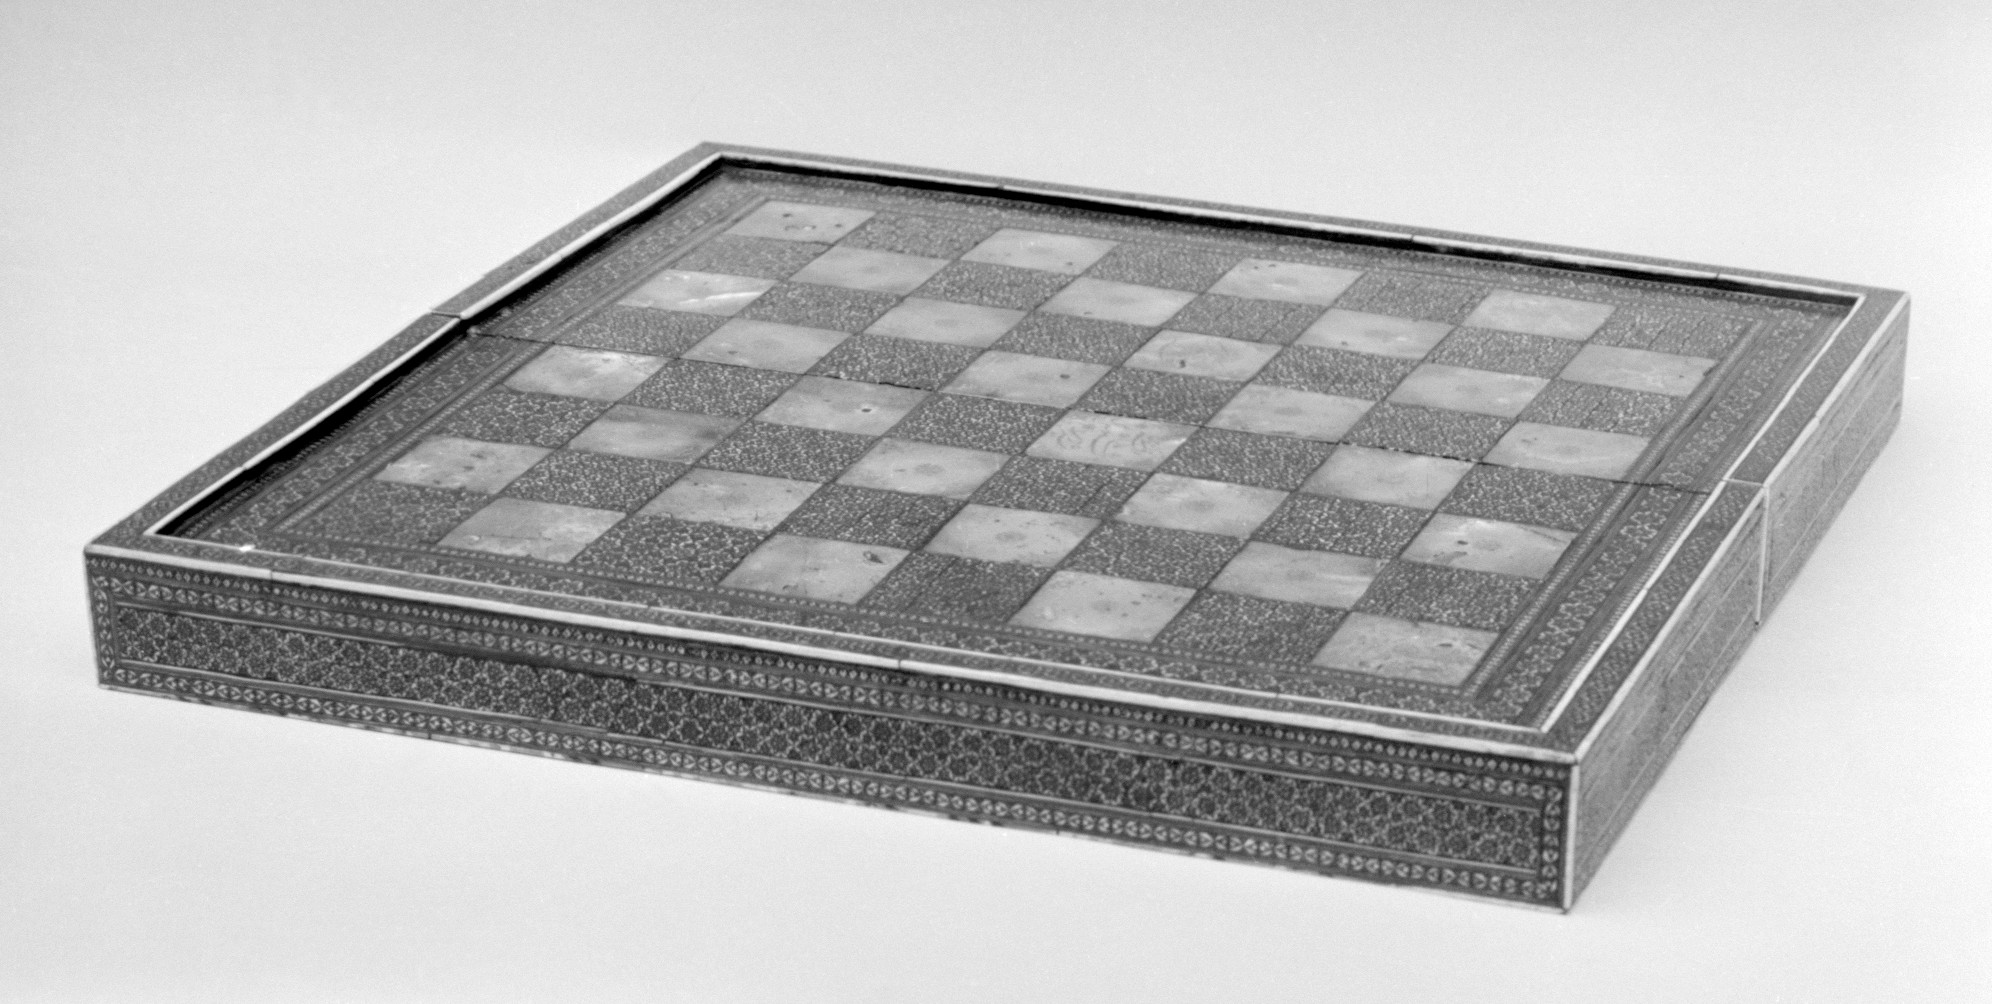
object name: chess and backgammon board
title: Box-board for chess and backgammon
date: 1801-1900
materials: bone, brass, mother of pearl, wood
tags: chess